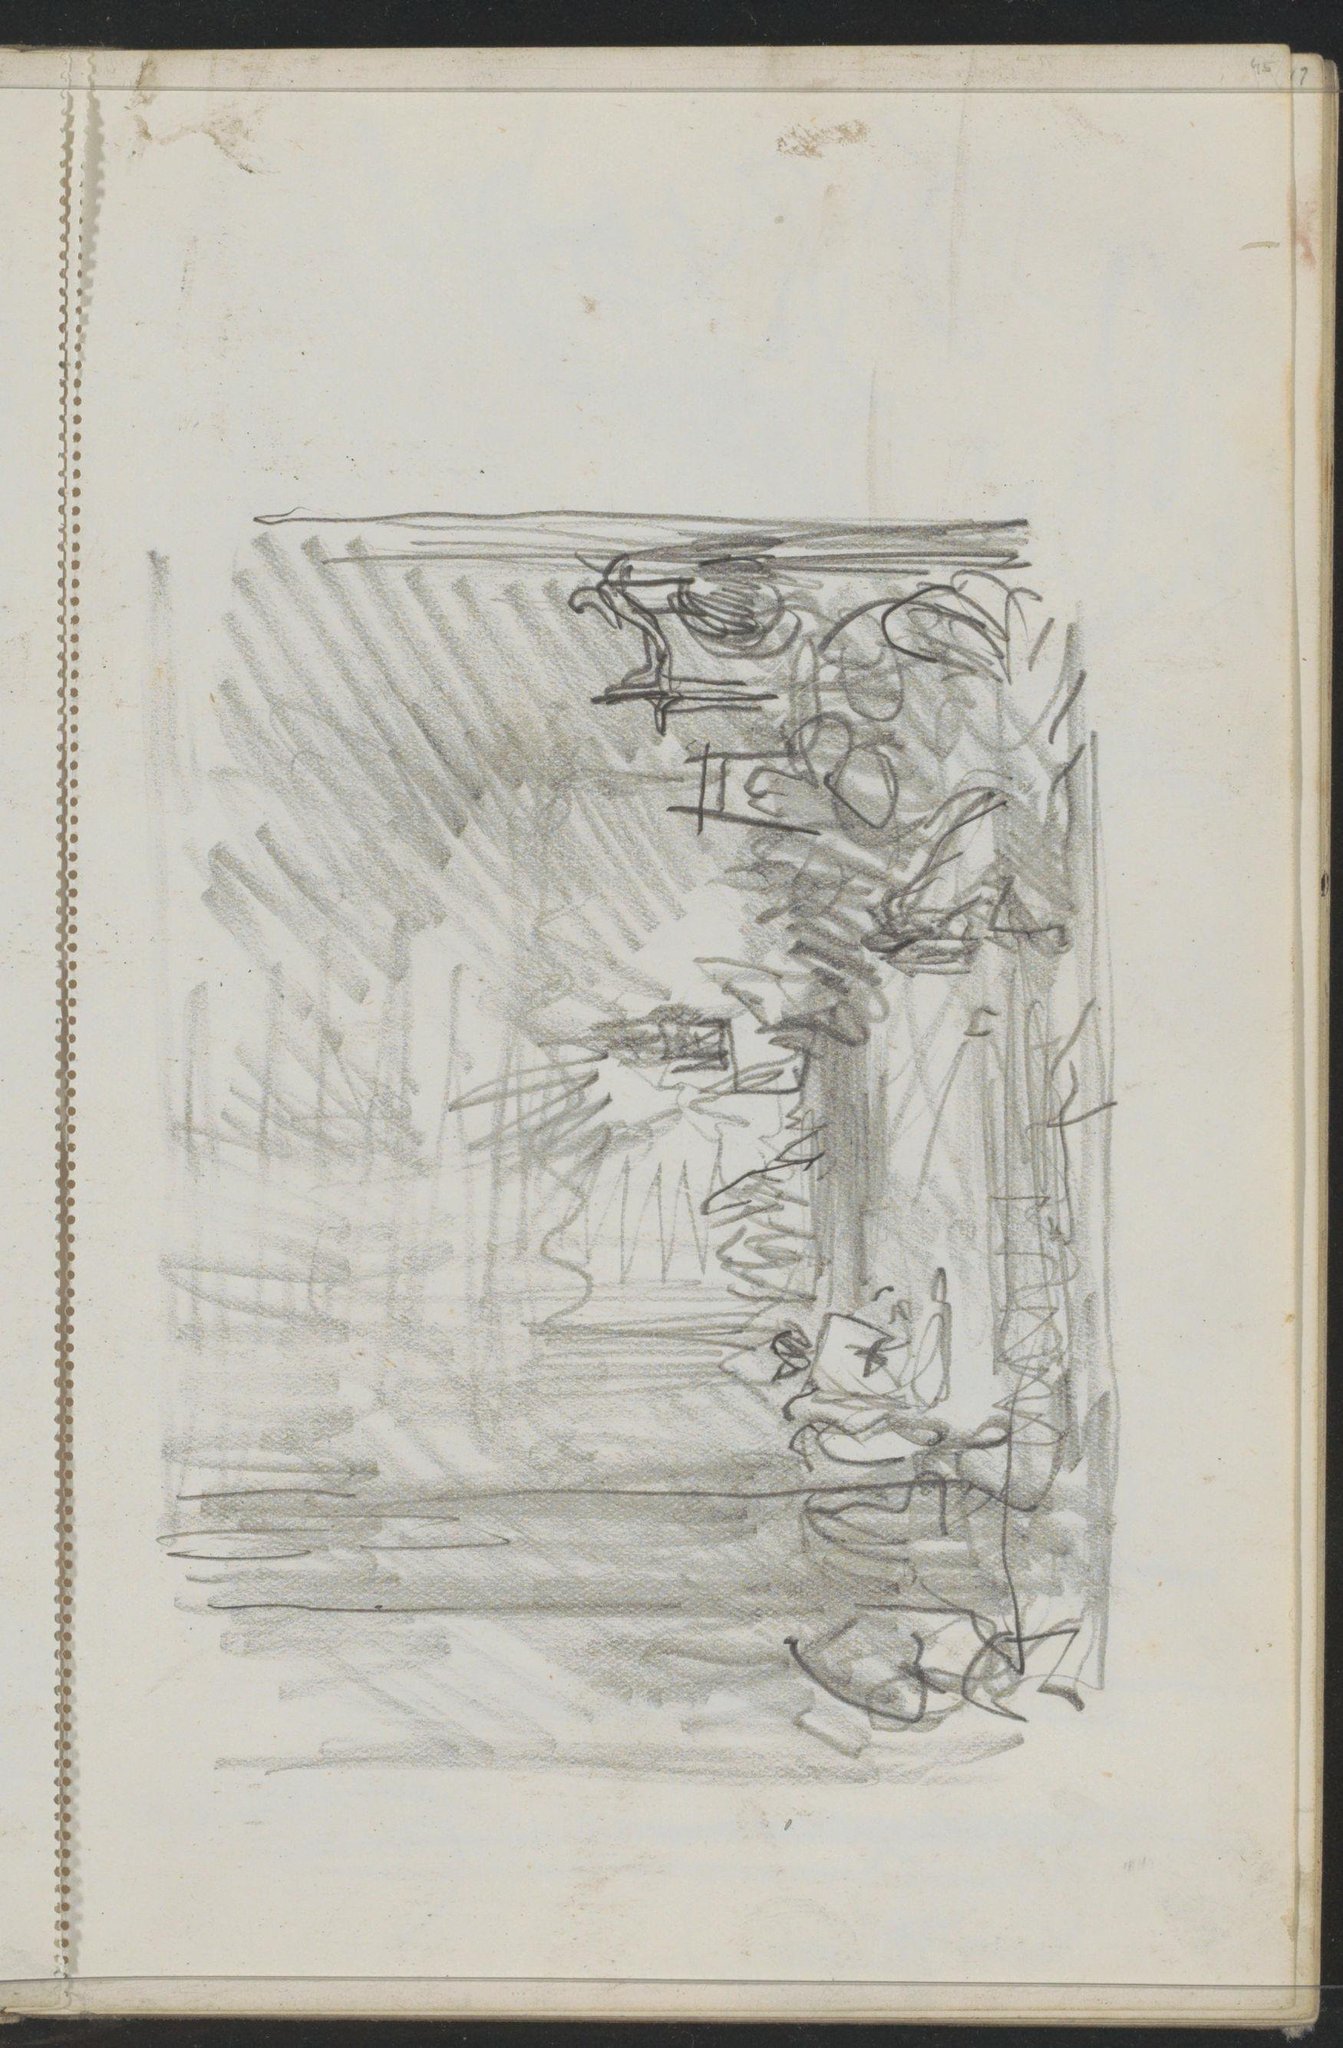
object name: sketchbook leaf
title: Voorstelling op een podium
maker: marius bauer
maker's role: draughtsman, print maker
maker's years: 1867-1932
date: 1925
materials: paper, pencil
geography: indonesia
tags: set, scenery ~ stage, performance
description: Pagina 45 uit een schetsboek met 74 bladen.